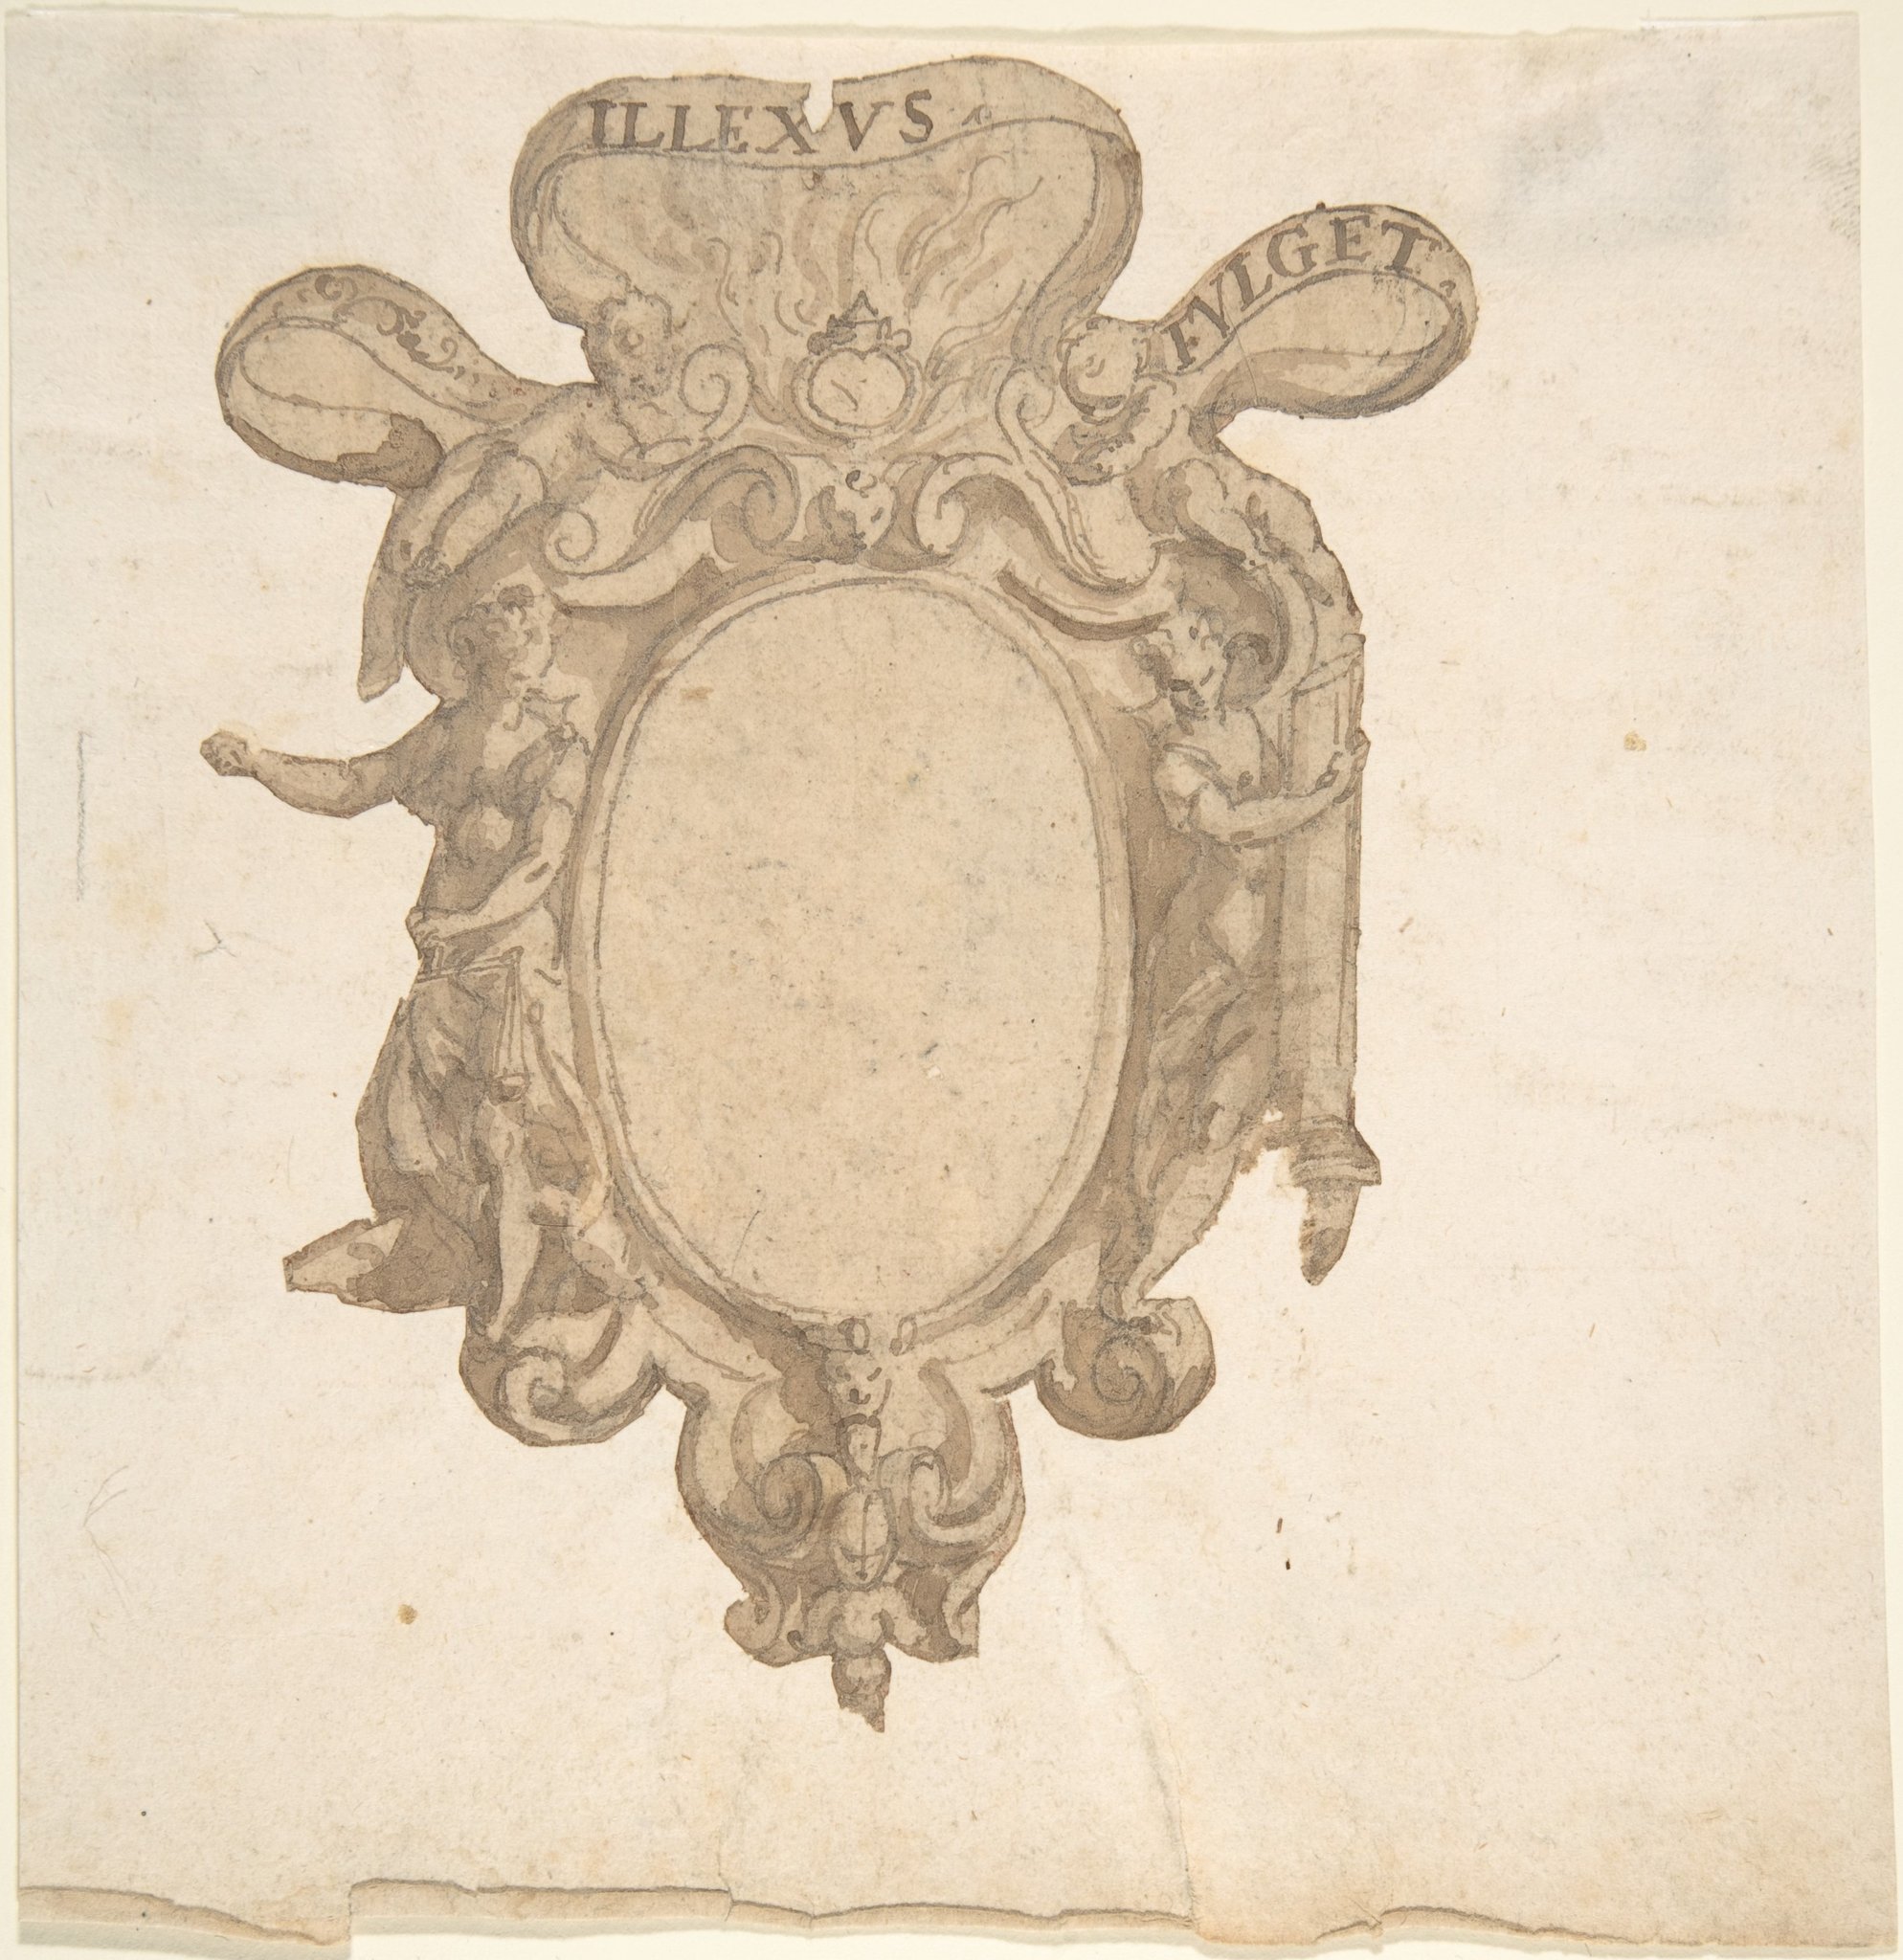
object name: drawing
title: Design for a Coat of Arms Surmounted by a Ring with Allegorical Figures of Justice and Fortitude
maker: anonymous, italian, 16th to 17th century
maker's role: artist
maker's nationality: italian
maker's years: 1500-1700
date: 1501-1700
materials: chalk, ink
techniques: brush, pen, drawing, wash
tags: coat of arms